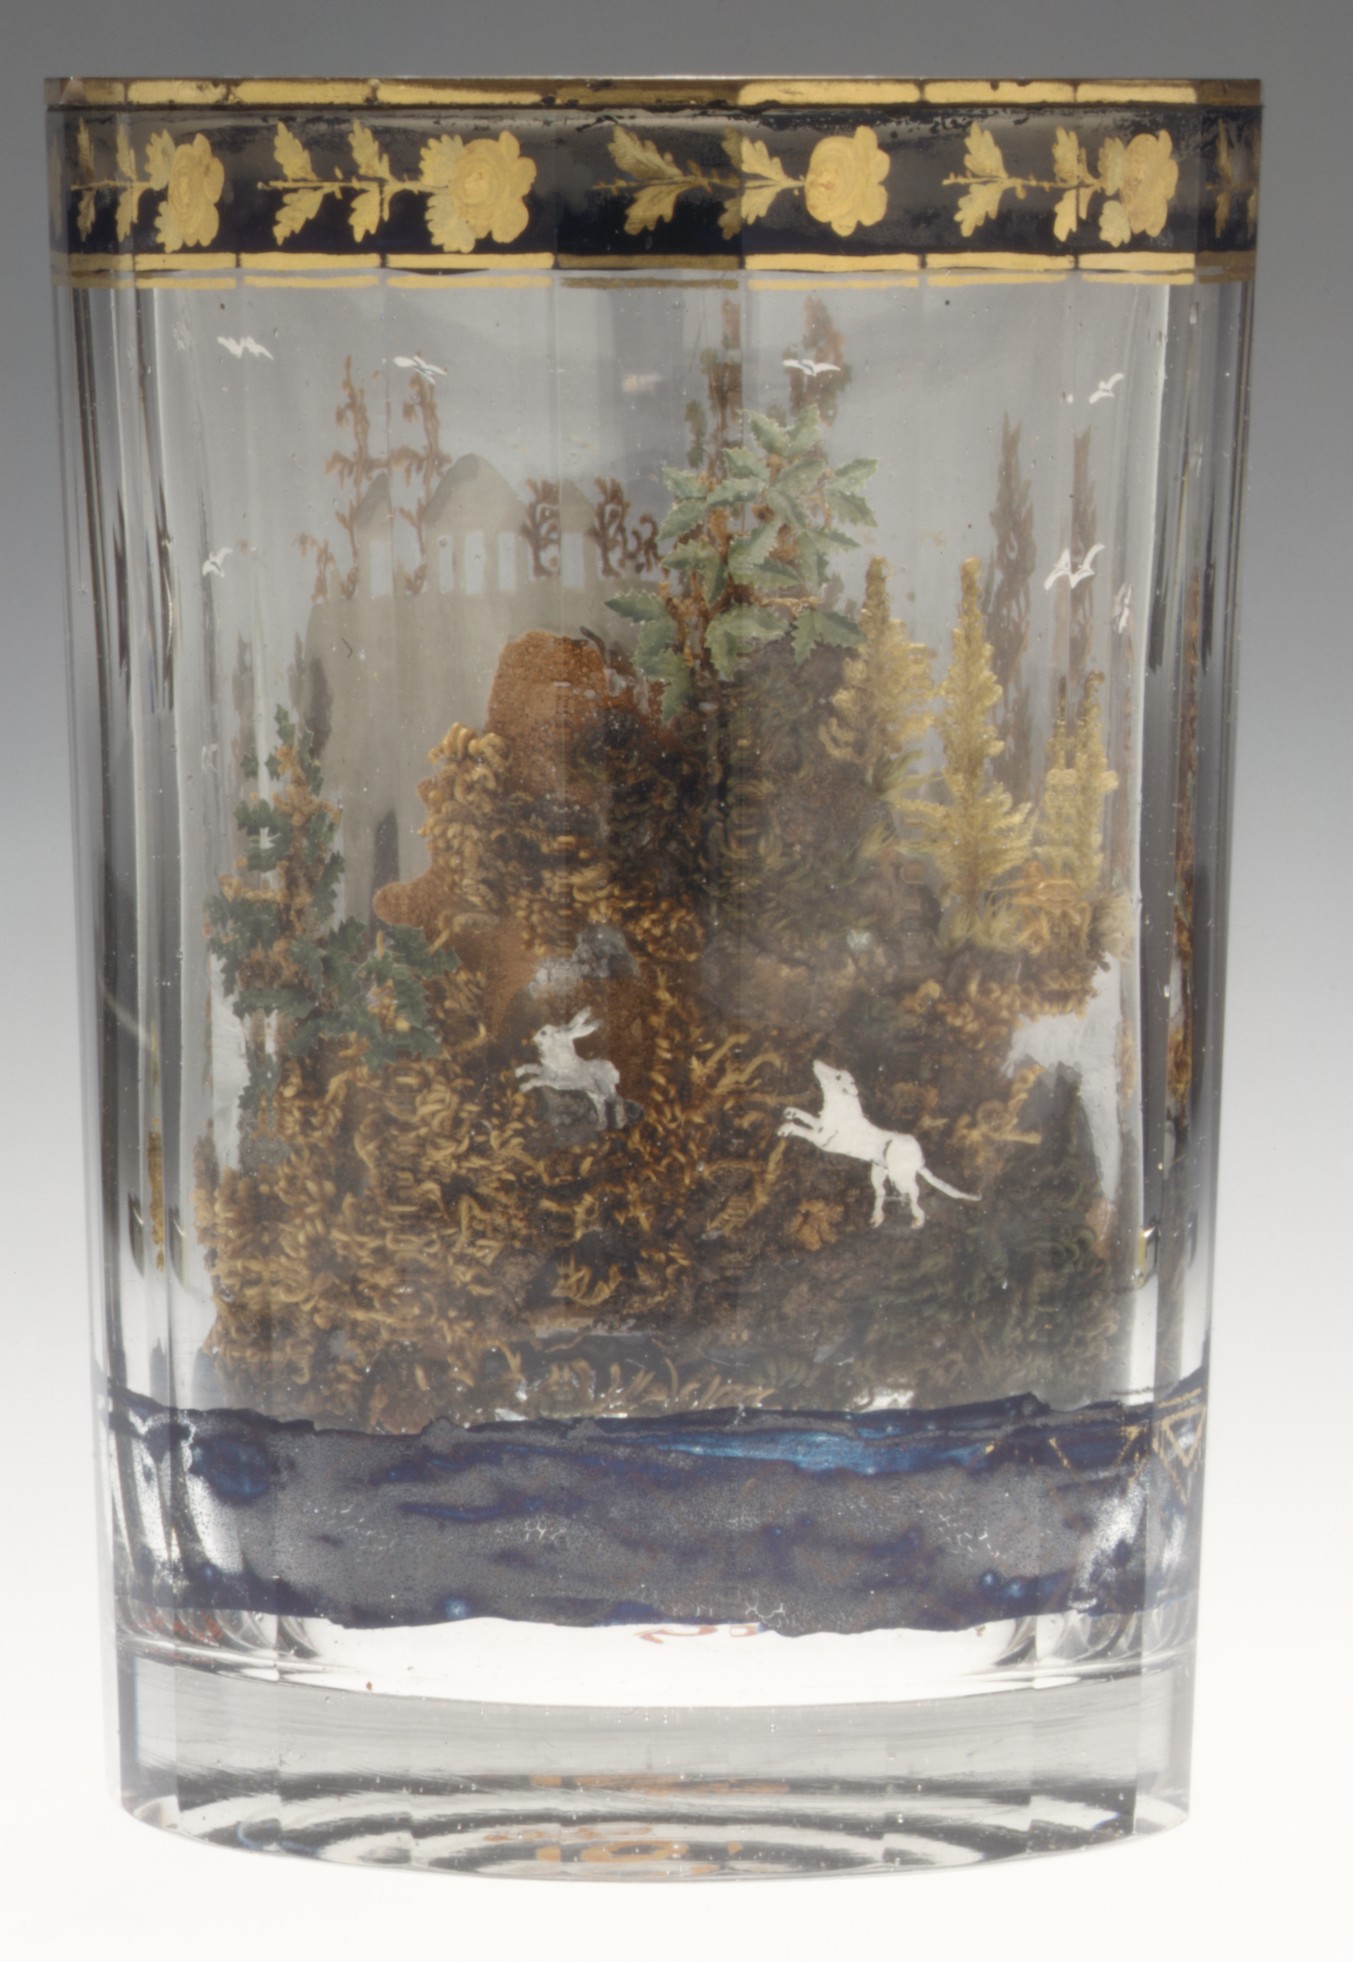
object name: beaker or tumbler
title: Dog chasing a rabbit in a landscape with dacha and hut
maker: alexander vershinin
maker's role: artist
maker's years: 1795-1822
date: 1800-1810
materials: clay, enamel, glass, mica, paper, stone, fiber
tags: birds,dogs,rabbits,landscapes